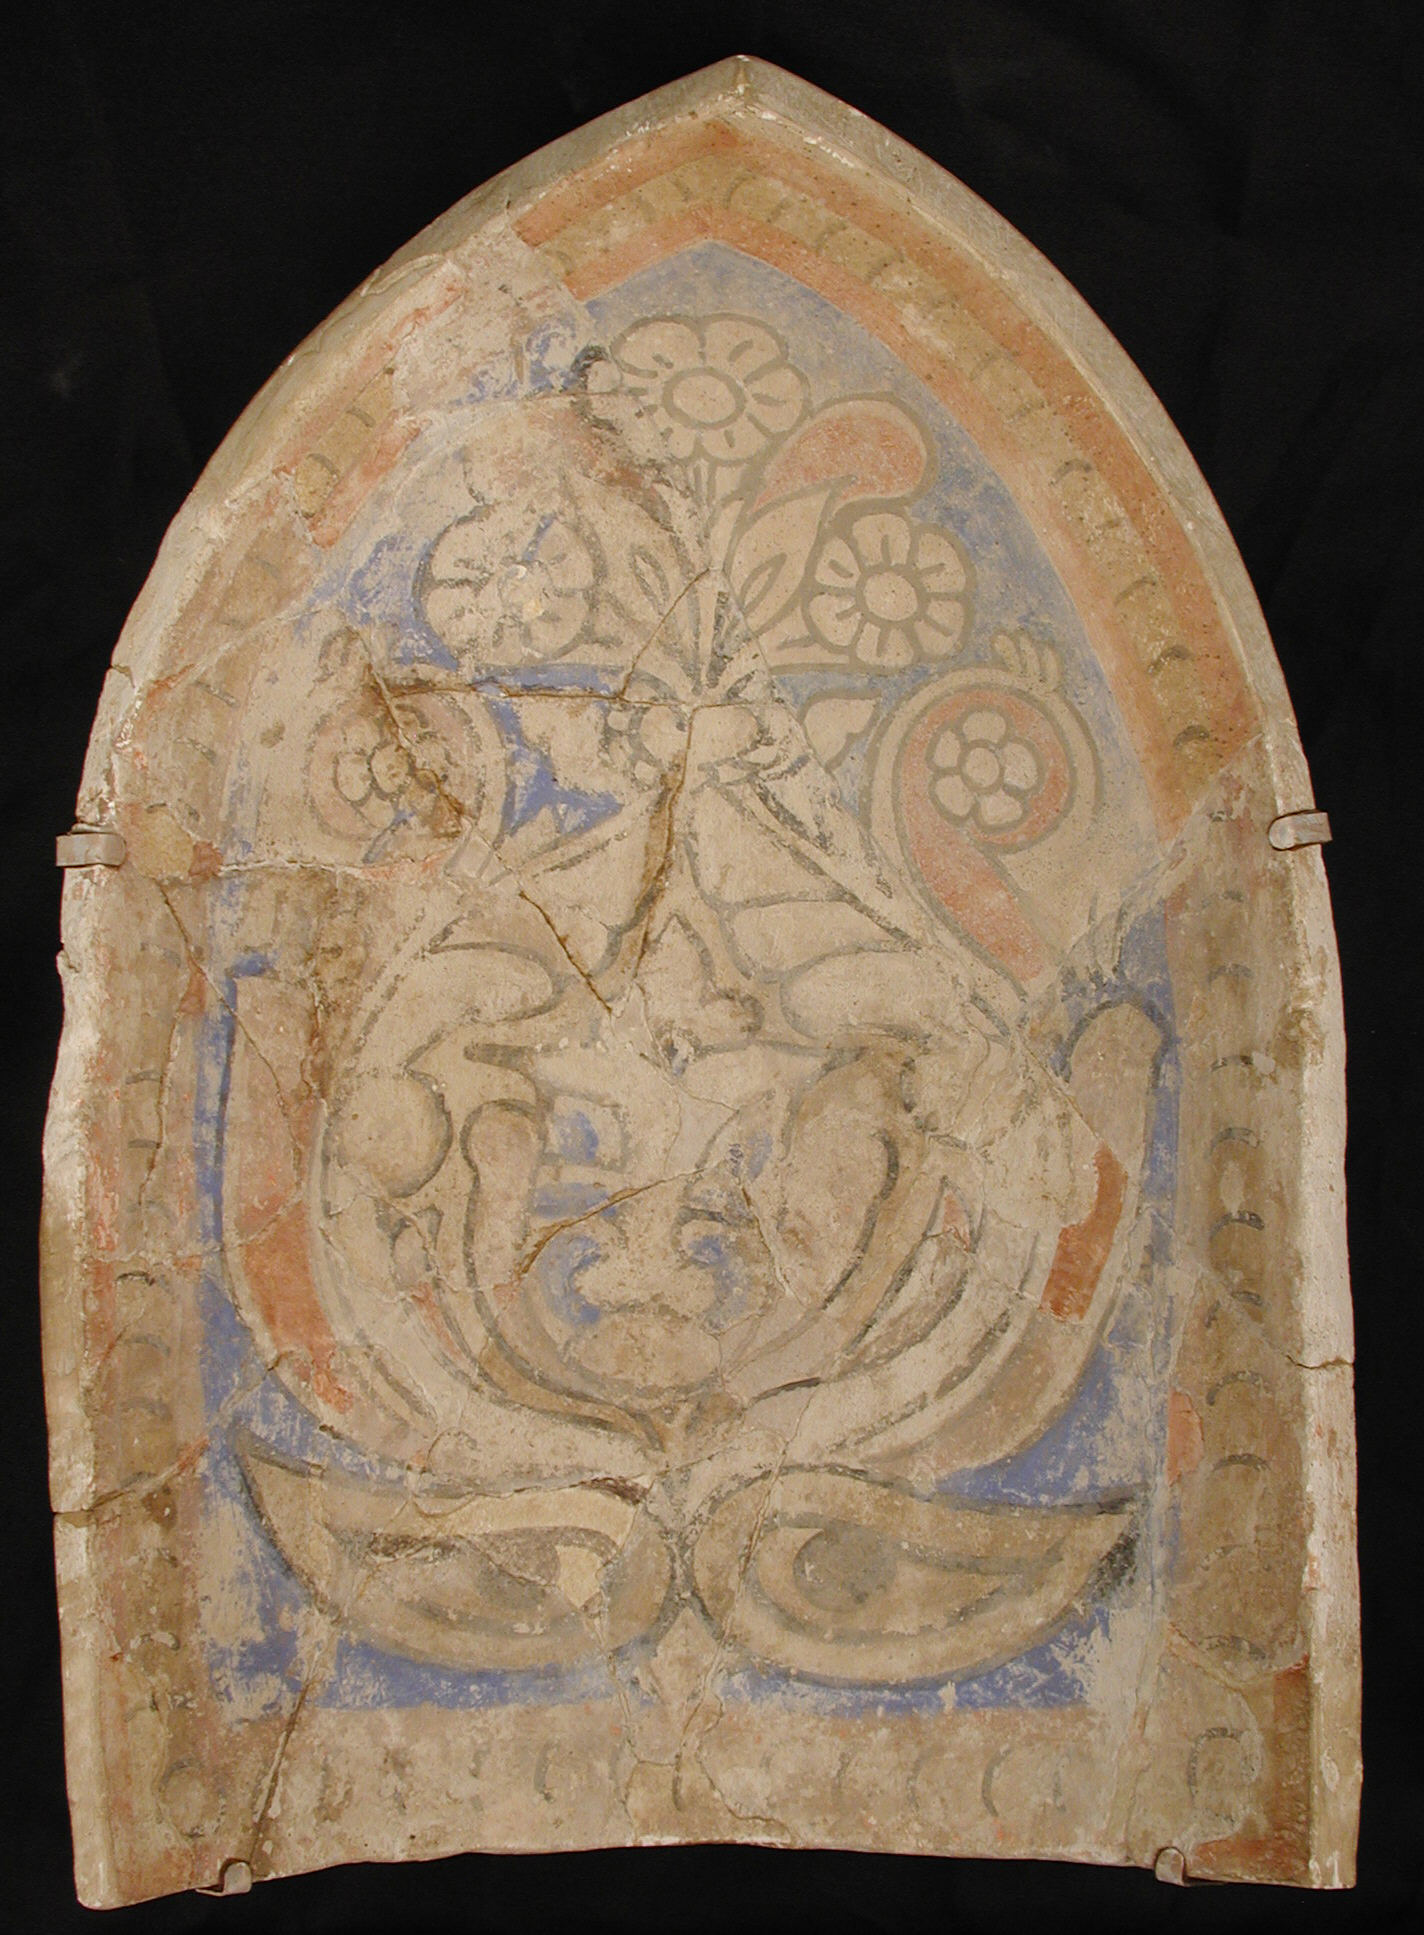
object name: squinch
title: Element from a Stalactite Squinch (Muqarnas)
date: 901-1000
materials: plaster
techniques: painting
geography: iran